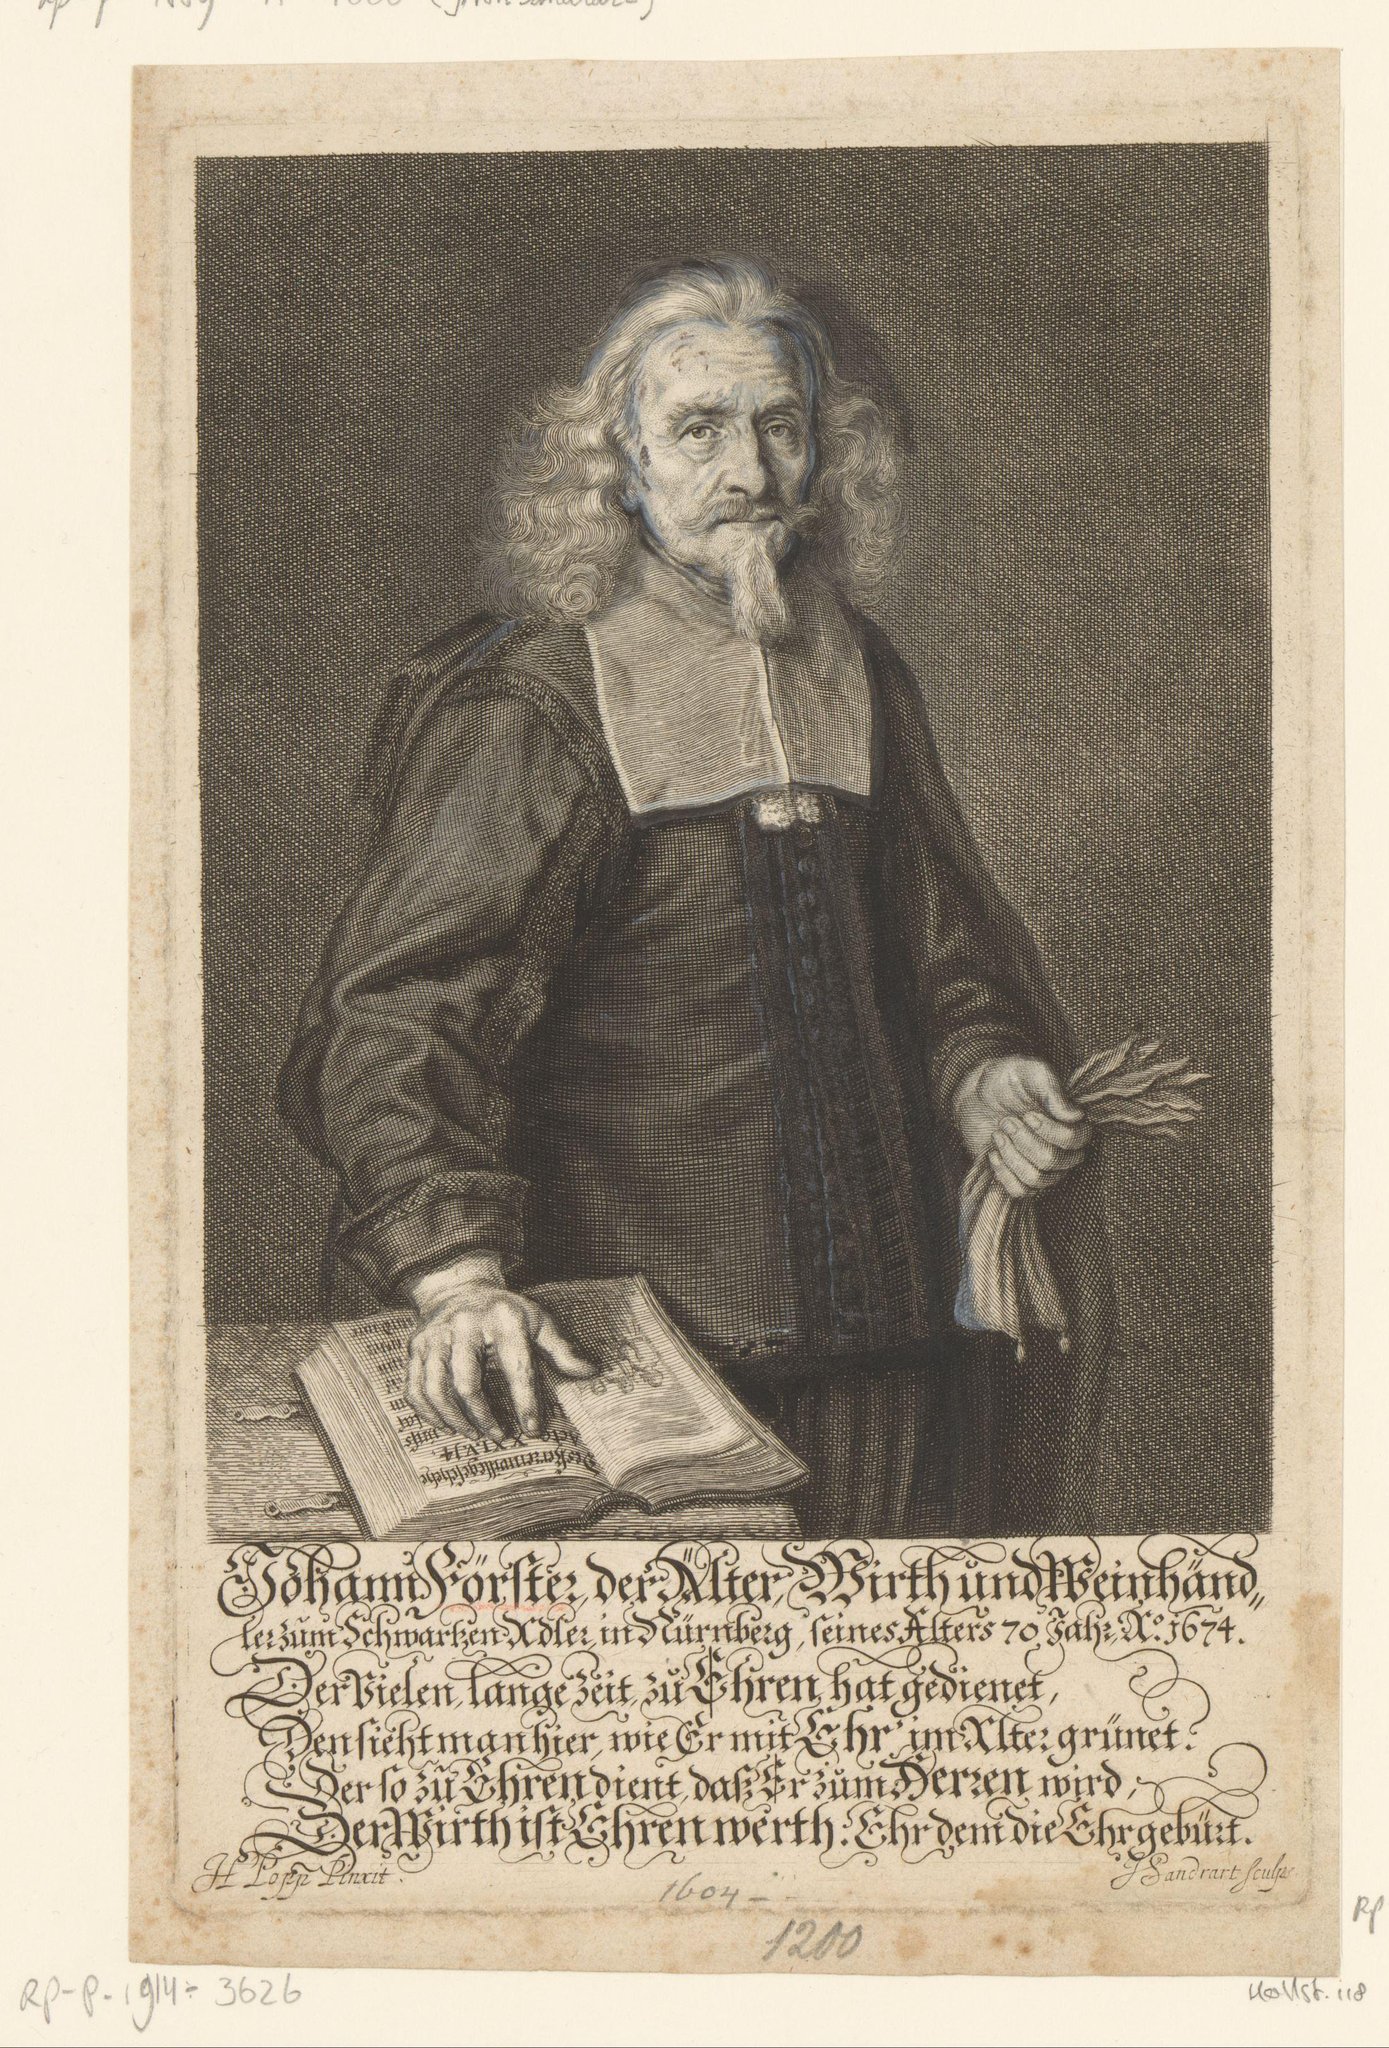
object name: print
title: Portret van Johann Förster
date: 1674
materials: paper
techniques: engraving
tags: historical persons, book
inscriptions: collector's mark: Lugt 2228